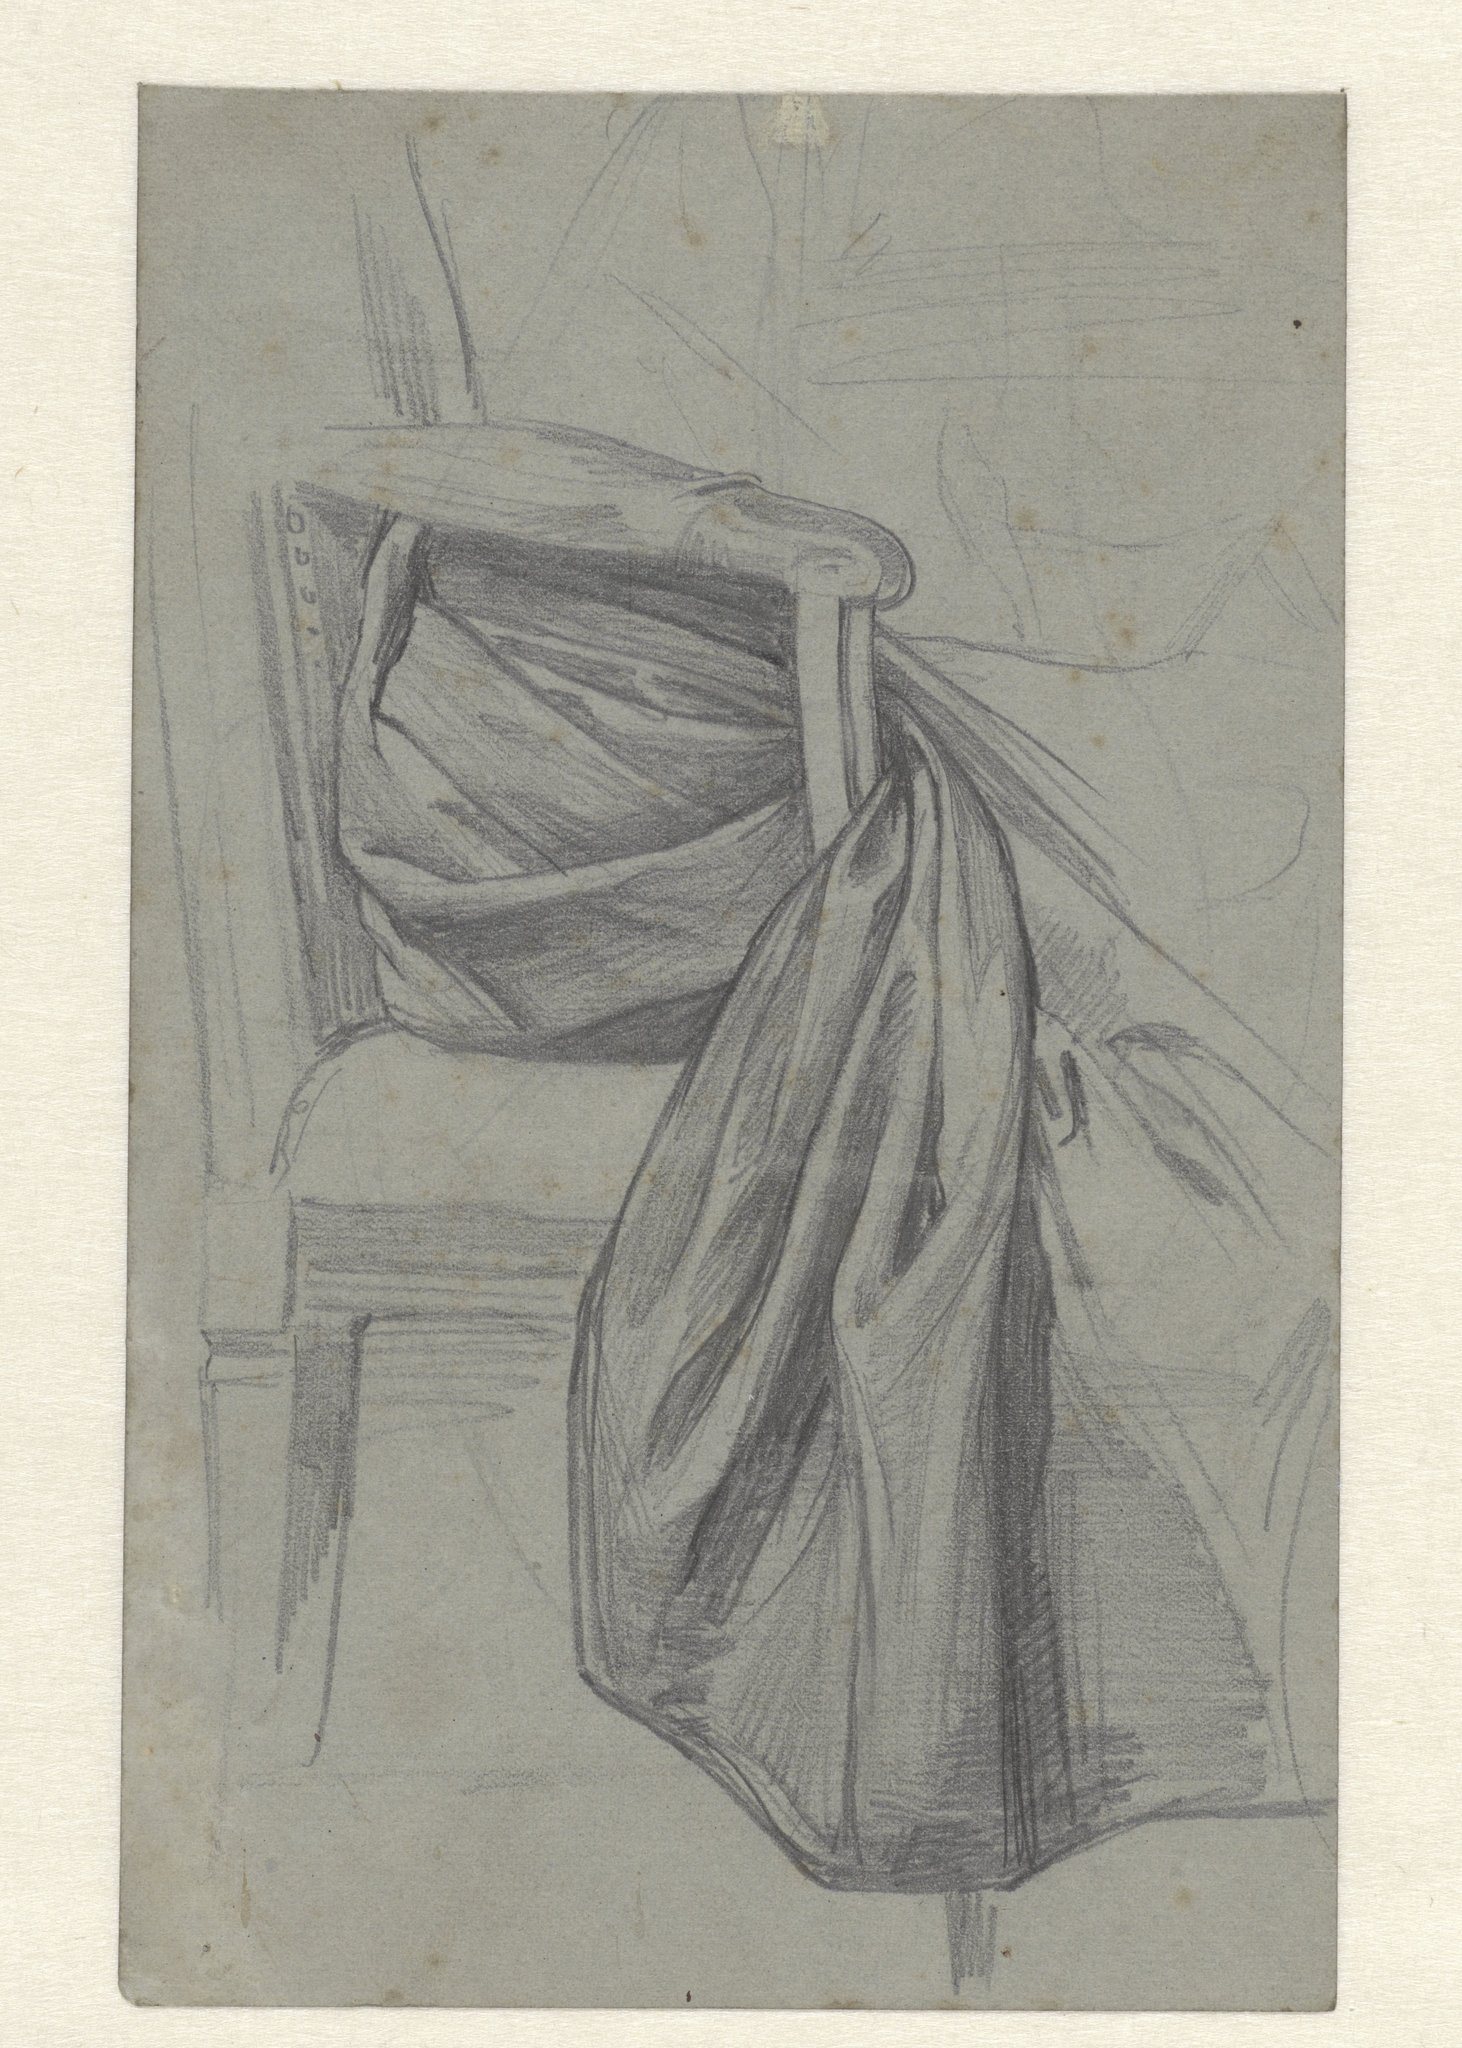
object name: drawing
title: Draperiestudie van een rok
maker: jac van looij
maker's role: draughtsman, painter, print maker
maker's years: 1855-1930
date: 1865-1930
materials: paper, pencil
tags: drapery, draped garment, 'gewandgebung'